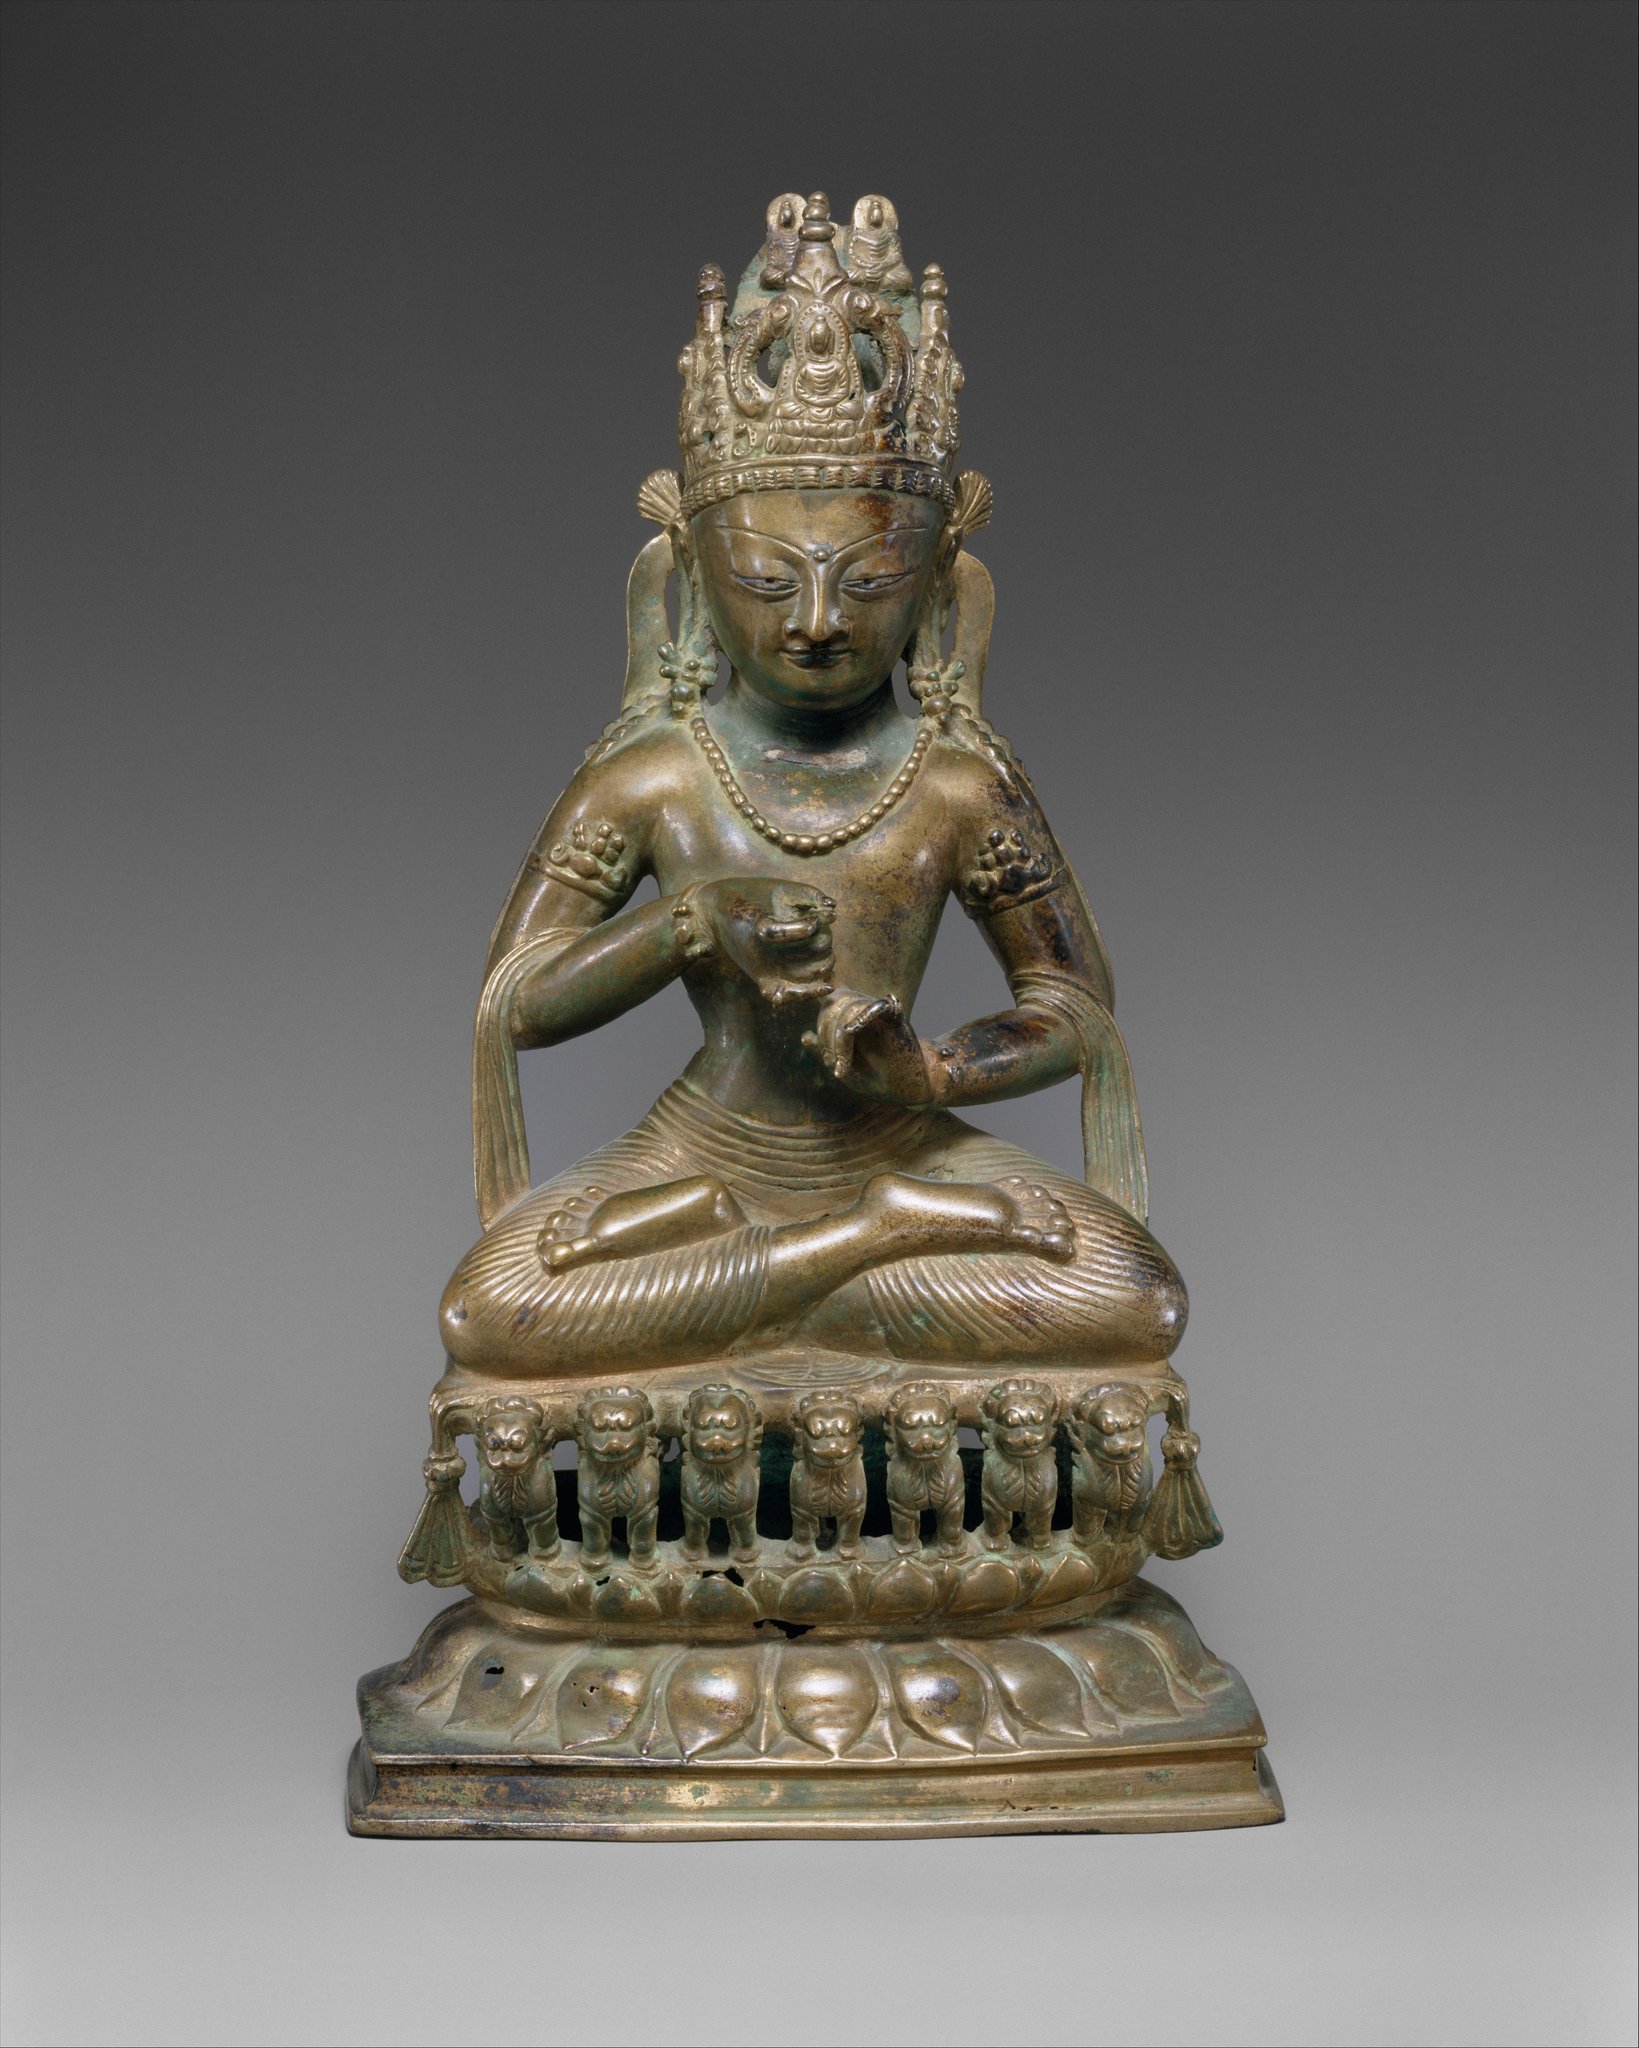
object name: figure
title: Vairochana, the Transcendent Buddha of the Center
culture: pakistani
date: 801-933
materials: bronze, silver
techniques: inlay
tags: swat valley,lions,buddhism,buddha